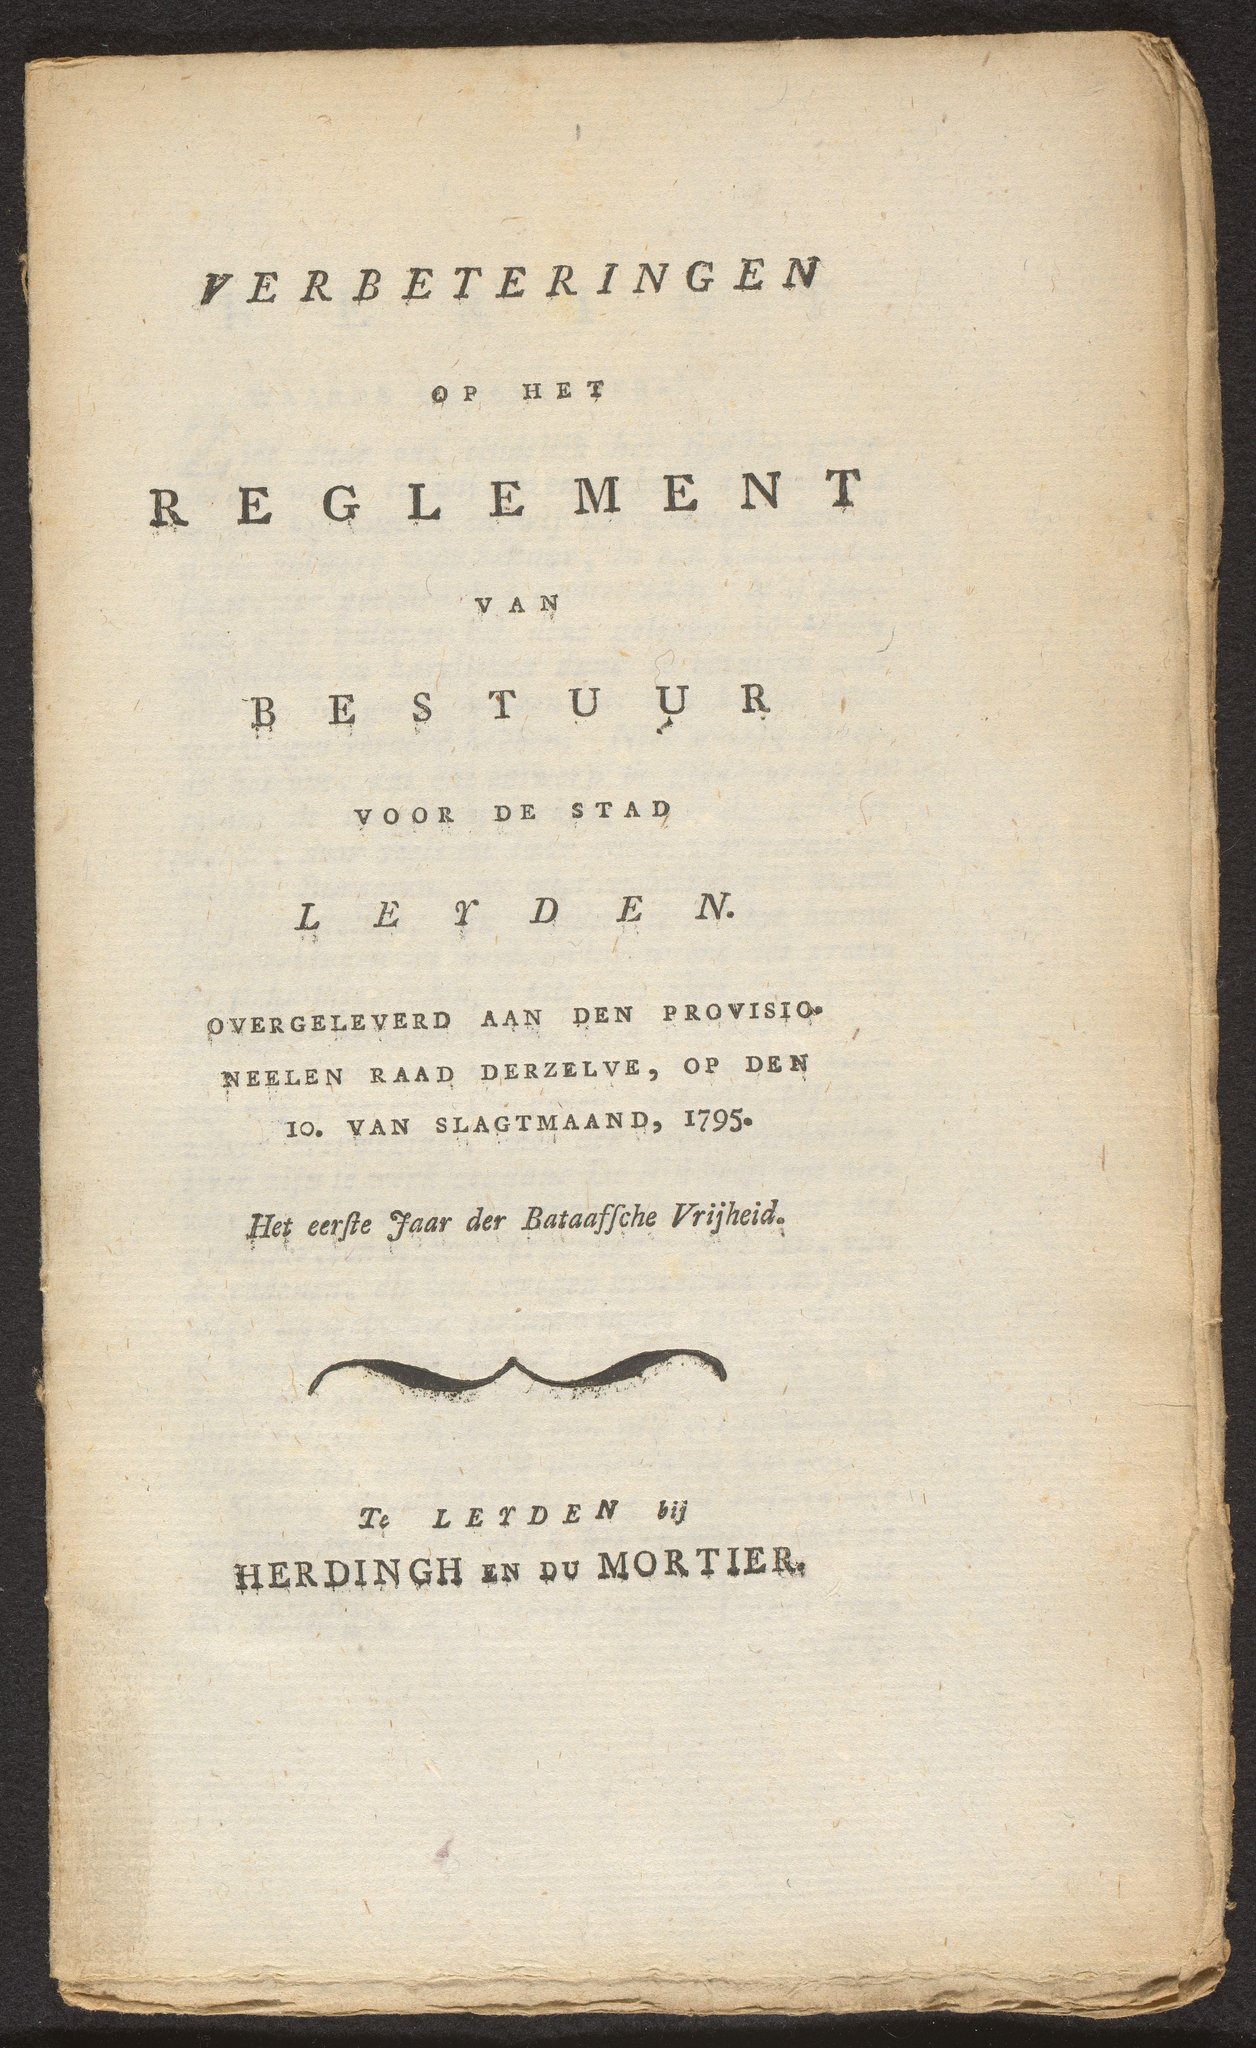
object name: brochure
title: Verbeteringen op het regelement van bestuur voor de stad Leyden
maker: leendert herdingh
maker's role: publisher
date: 1795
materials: paper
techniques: printing, sewing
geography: leiden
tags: leiden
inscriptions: date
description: 21 genummerde pp, zonder omslag. Gedateerd; titelp.: 1795 ('Het eerste Jaar der Bataaffsche Vrijheid').